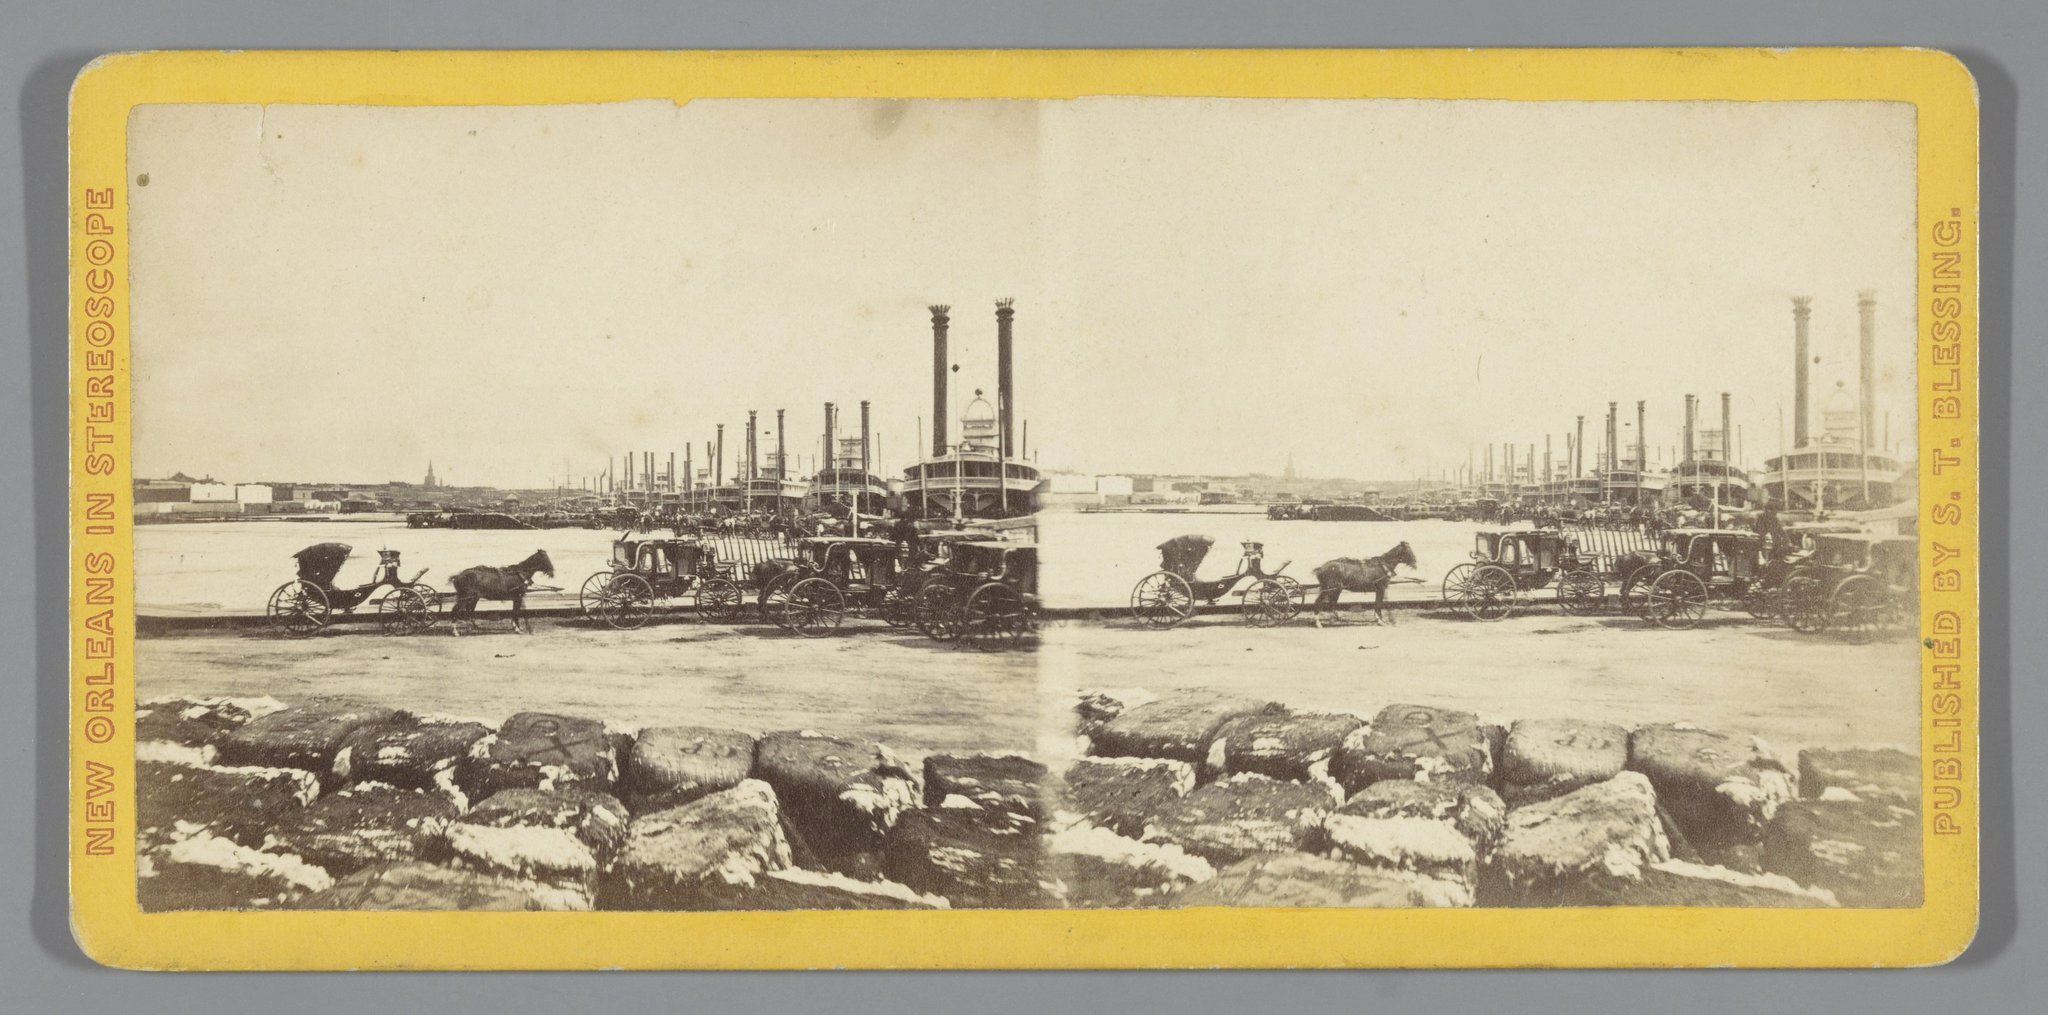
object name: stereograph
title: Levee and River Views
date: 1863-1897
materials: cardboard, paper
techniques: albumen print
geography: new orleans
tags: harbour, four-wheeled, animal-drawn vehicle, e.g.: cab, carriage, coach, steamship, motorship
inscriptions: number: ‘No. 101’